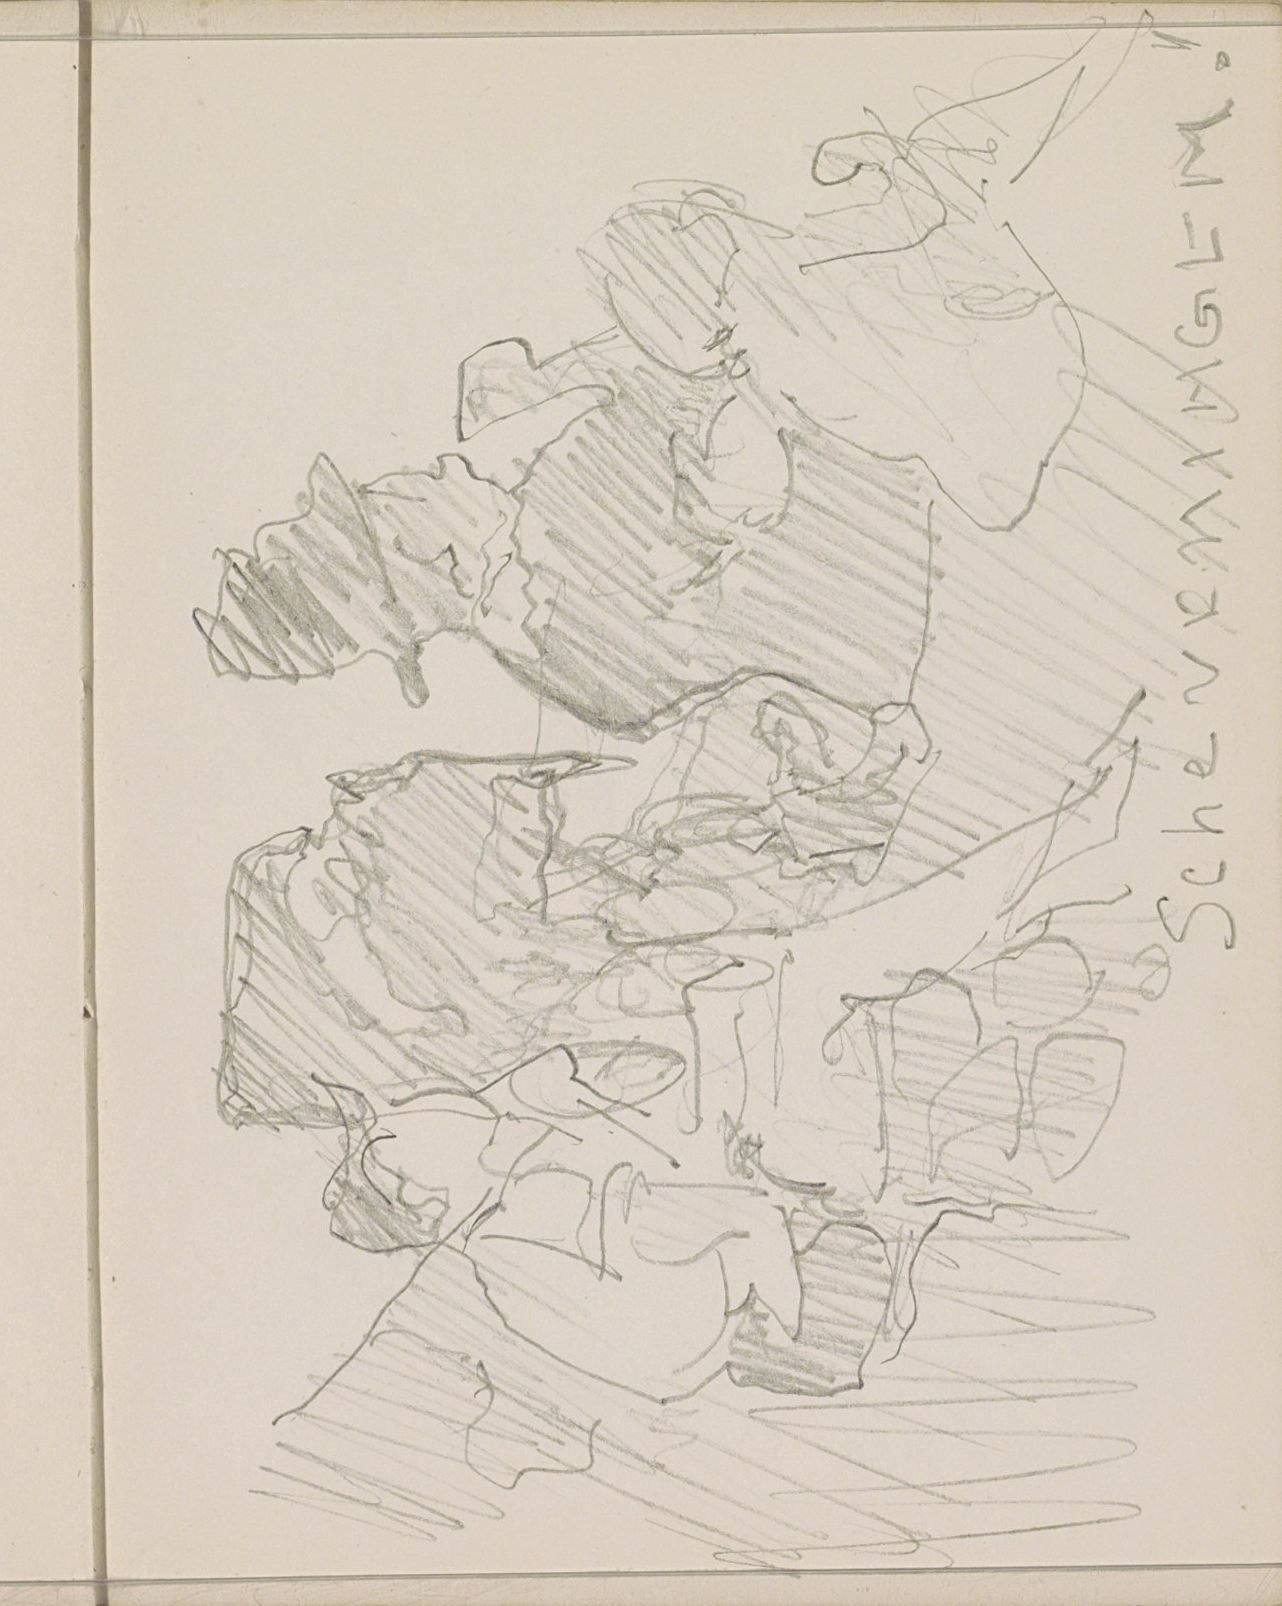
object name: sketchbook leaf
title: Figuren op het strand van Scheveningen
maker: reijer stolk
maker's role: draughtsman, print maker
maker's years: 1896-1945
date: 1916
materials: paper, pencil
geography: scheveningen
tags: beach (+ landscape with figures, staffage)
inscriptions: annotation: ‘SCHEVENINGEN!’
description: De figuren, waaronder een man met een hoge hoed en een meisje, zitten naast een kinderwagen op het strand. Blad 43 recto uit een schetsboek met 72 bladen.